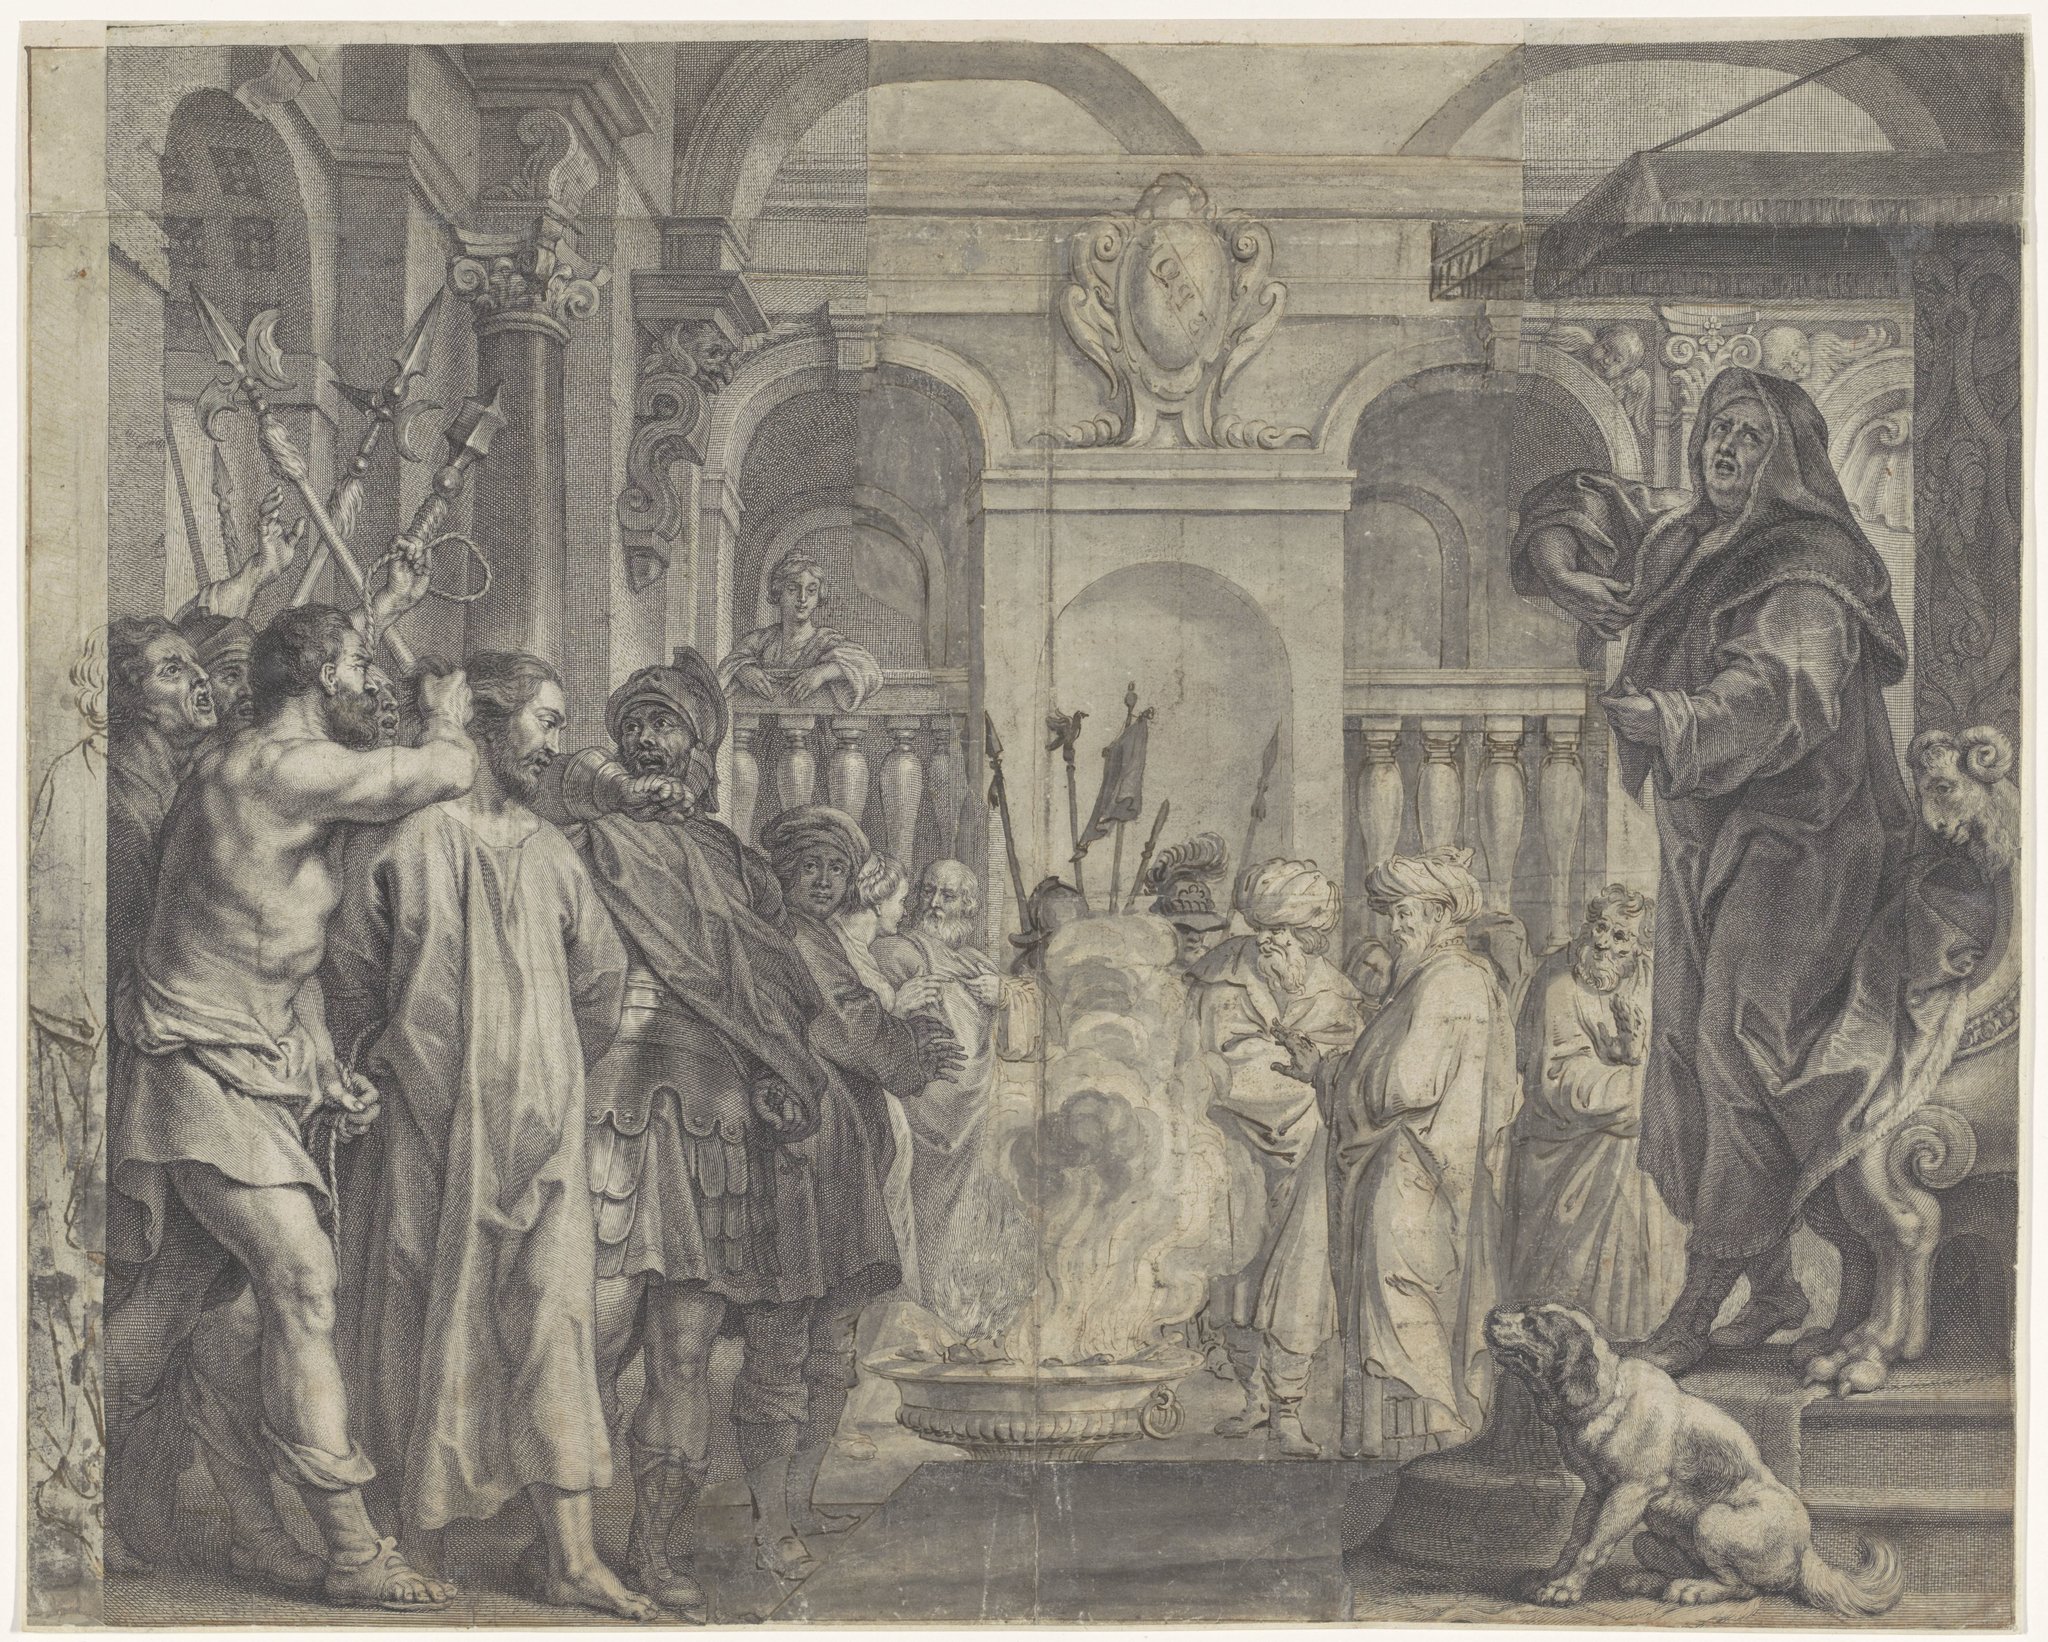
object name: design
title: Royaalbijbel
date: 1630-1652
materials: ink, paper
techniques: brush, engraving, pen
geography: amsterdam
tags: christ before the sanhedrin with caiaphas as high priest, and possibly annas; maybe a soldier about to strike christ because he keeps silent (matthew 26:57-66; mark 14:53-64; luke 22:54, 22:66-71), caiaphas tearing his clothes ~ trial of christ, story of the denial of peter (matthew 26:58, 26:69-75; mark 14:54, 14:66-72; luke 22:55-62; john 18:15-18, 18:25-27)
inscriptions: collector's mark: Lugt 240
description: De Amsterdamse uitgever Claes Jansz. Visscher (II) produceerde vanaf de jaren ’30 van de zeventiende eeuw grote Bijbelse prenten op zogenaamd royaal-formaat papier (ca. 480 x 580 mm). Na zijn dood in 1652 zette zijn zoon Nicolaes Visscher (I) het bedrijf voort en zo ook de uitgave van Royaalbijbelprenten. Toen Nicolaes in 1679 overleed nam zijn zoon Nicolaes Visscher (II) het bedrijf over en gaf kort hierna, omstreeks 1680, een fondslijst uit. Hierin worden 130 prenten met Bijbelse voorstellingen op royaalpapier beschreven (zie documentatie J. van der Waals). Complete prentbijbels op royaal-formaat werden door vader en zoon Nicolaes Visscher uitgegeven onder de titel Historiae Sacrae Veteris et Novi Testamenti. De bladen werden echter ook los verkocht en konden worden gecombineerd met Royaalbijbel-prenten van andere uitgevers. Verschillende Amsterdamse uitgevers brachten namelijk ook bijbelprenten op royaal-formaat uit, onder wie Clement de Jonghe en Cornelis Danckerts. De door de firma Visscher uitgegeven prenten zijn veelal vervaardigd door anonieme prentmakers naar voorbeeld van verschillende zestiende- en zeventiende-eeuwse Bijbelse prenten en prentreeksen. Veelal moesten de composities worden aangepast aan het grotere en langgerekte royaal-formaat. Daarnaast zijn er ook grote bladen van bekende prentmakers zoals Jan van Londerseel, Pieter Nolpe, Jacques de Gheyn (II) en Jan Harmensz. Muller opgenomen in de categorie ‘Bybelsche Figuren, op Royaal-bladen’ in de fondslijst van Visscher. Ontwerp voor de prent, die is gebruikt in: Historiae Sacrae Veteris et Novi Testamenti (Royaalbijbel). Amsterdam: Nicolaes Visscher (I) en (II), [1652-1702]. In de fondslijst van Nicolaes Visscher II (ca. 1680) is het onderwerp van deze uiteindelijke prent onder de titel 'Bybelsche Figuren, op Royaal-bladen. bestaande uyt de volgende historien.' als volgt genummerd: 109.